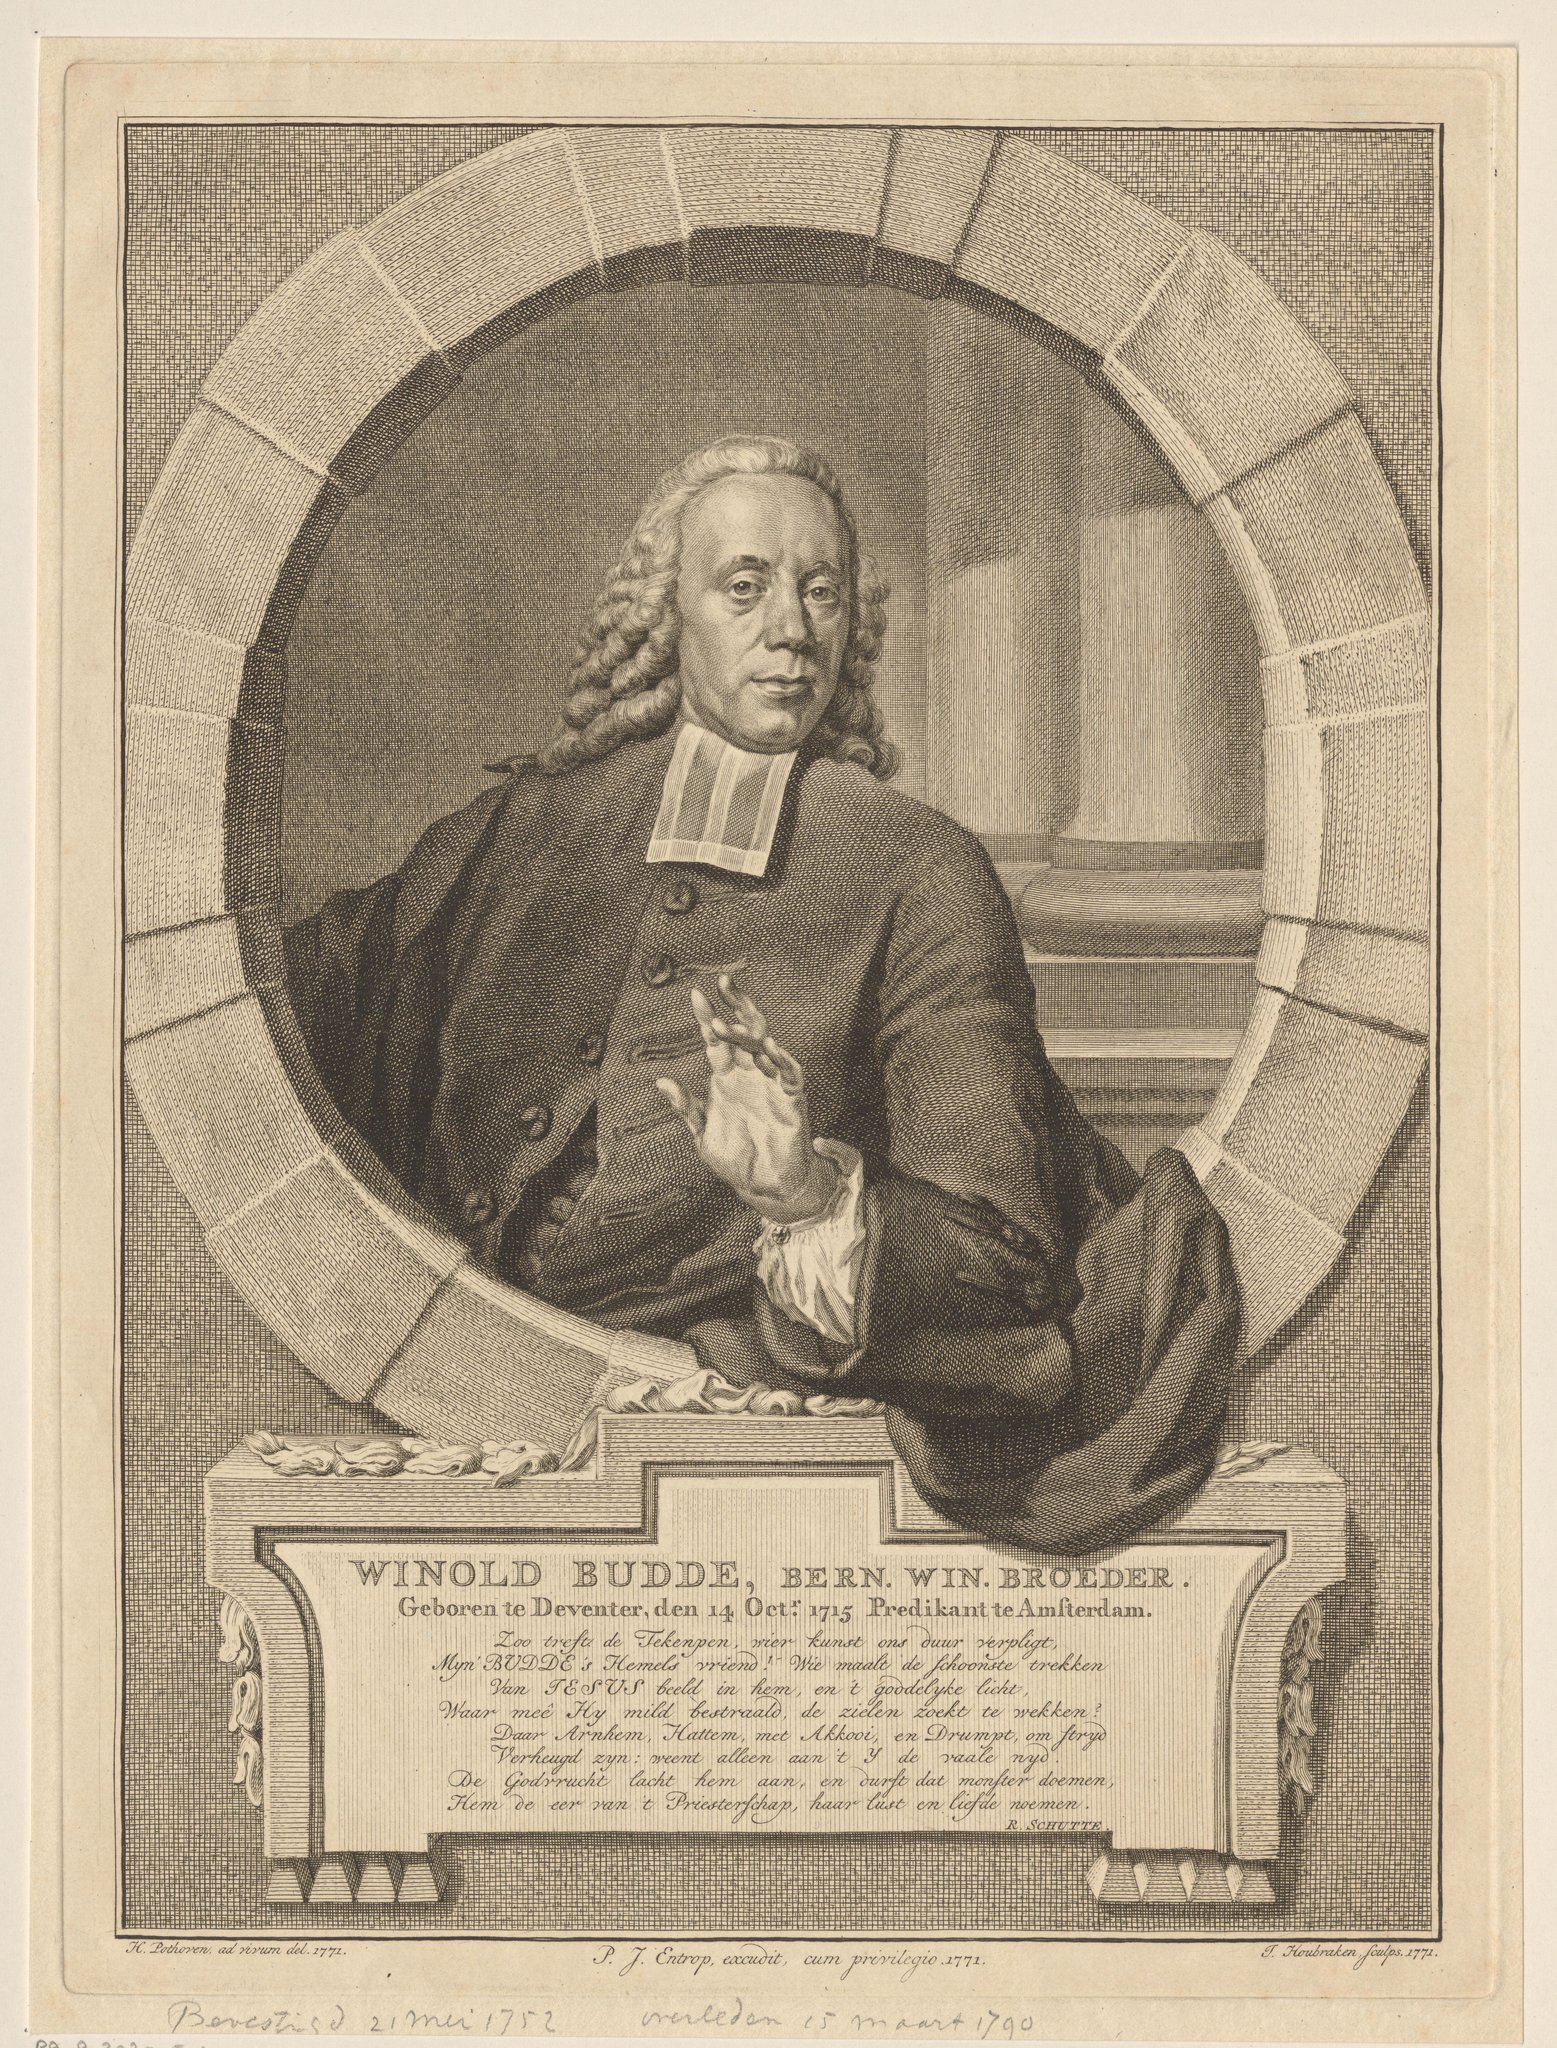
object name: print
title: Portret van Winoldus Budde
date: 1771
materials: paper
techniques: engraving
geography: amsterdam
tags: deventer, amsterdam, historical persons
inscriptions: date